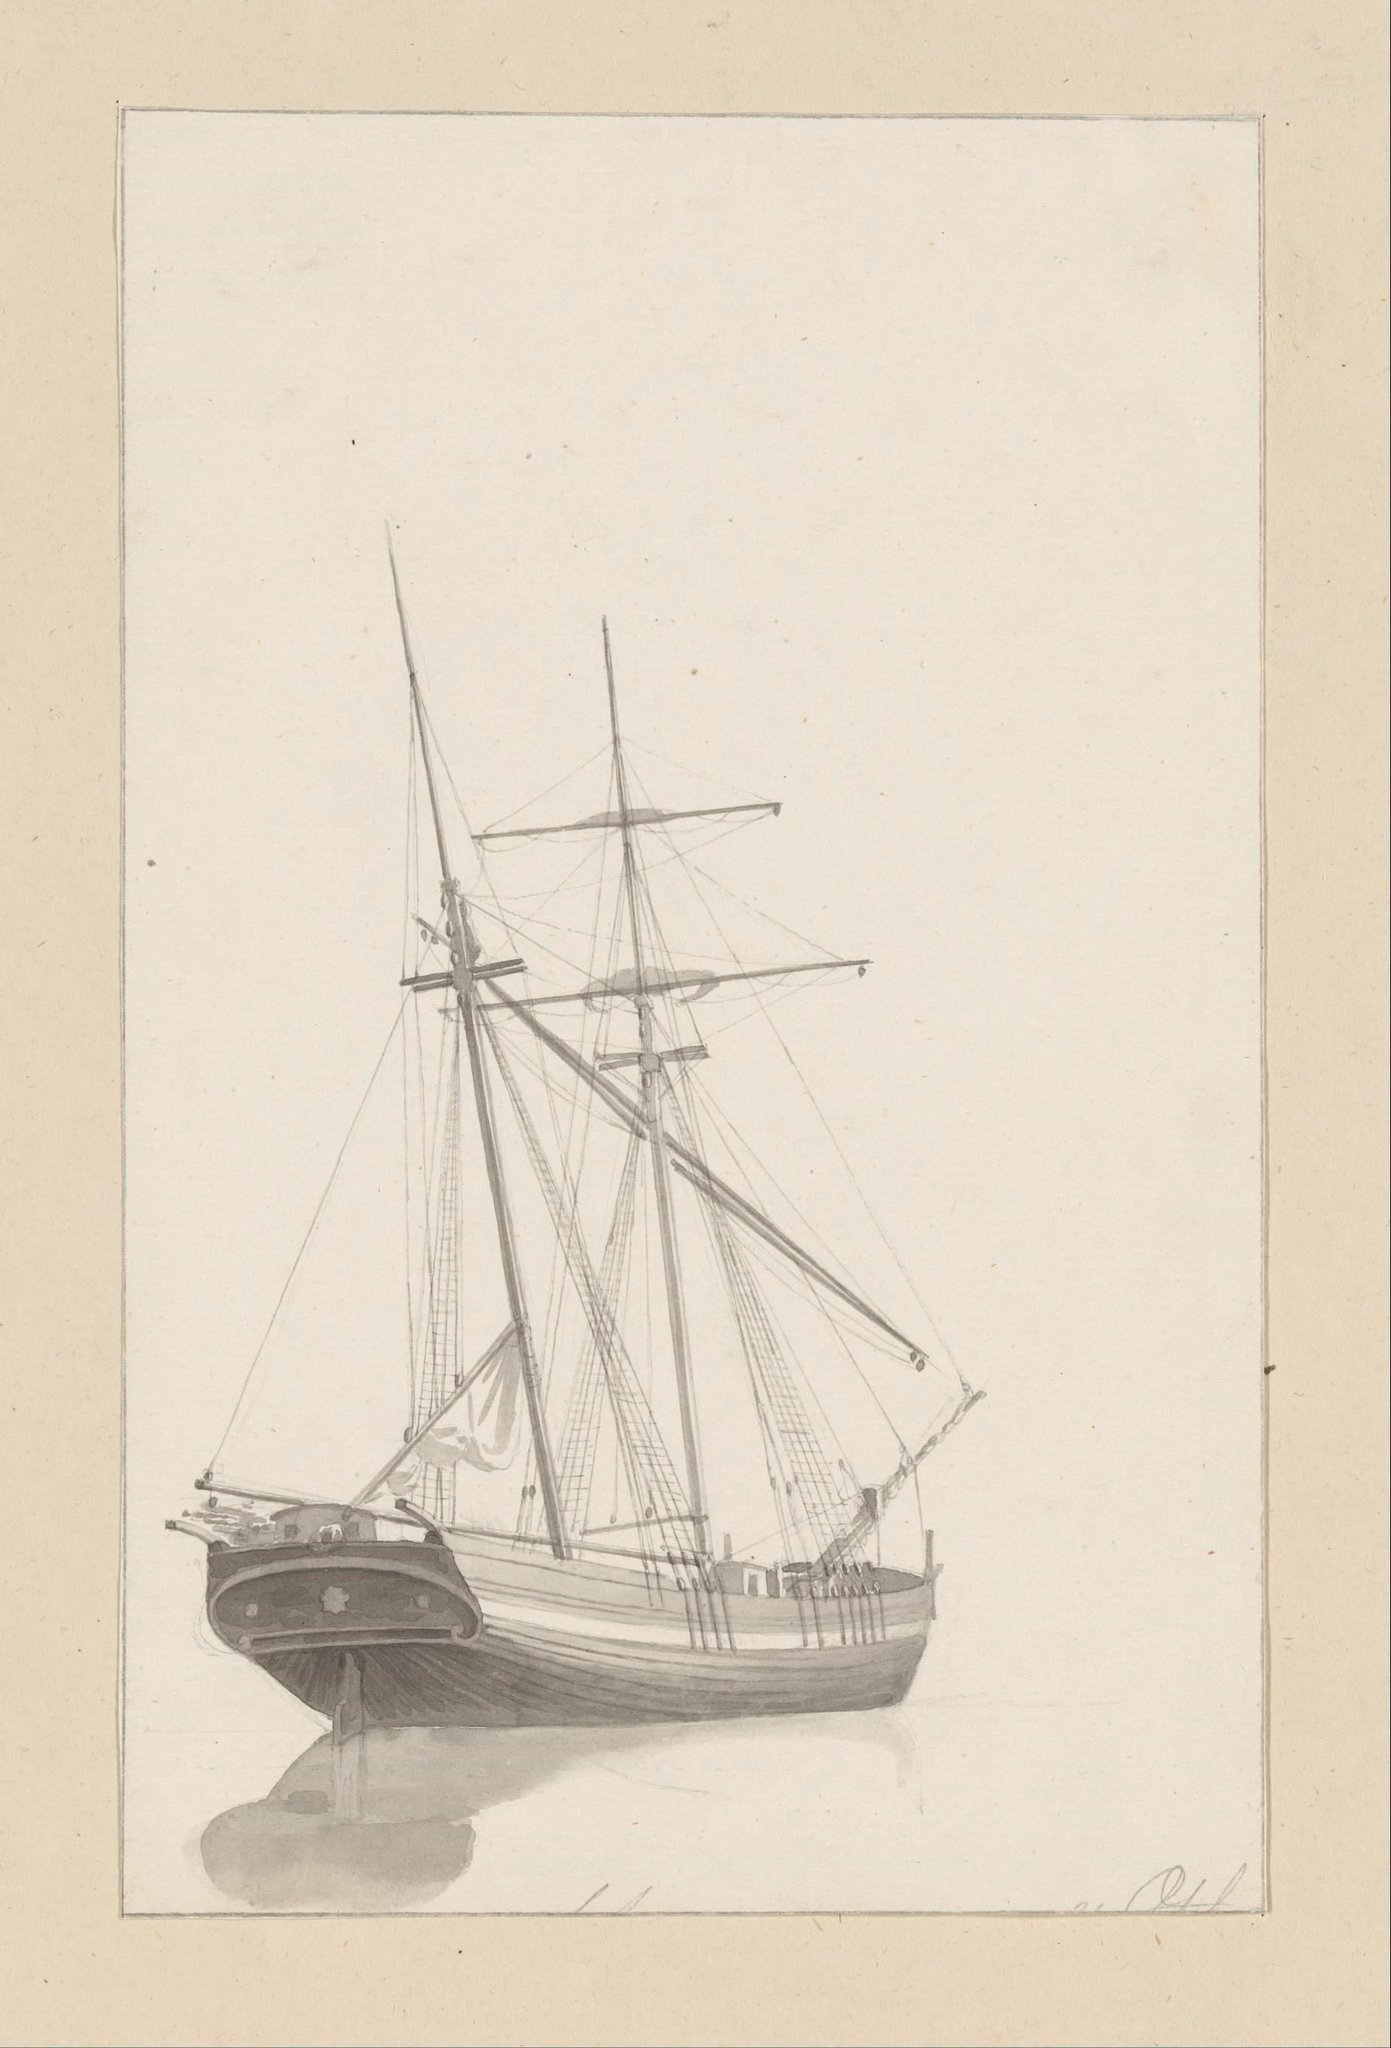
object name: drawing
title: Zeilschip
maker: hendrik abraham klinkhamer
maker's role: draughtsman, painter, print maker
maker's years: 1810-1872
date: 1820-1872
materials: paper, pencil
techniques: brush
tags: sailing-ship, sailing-boat